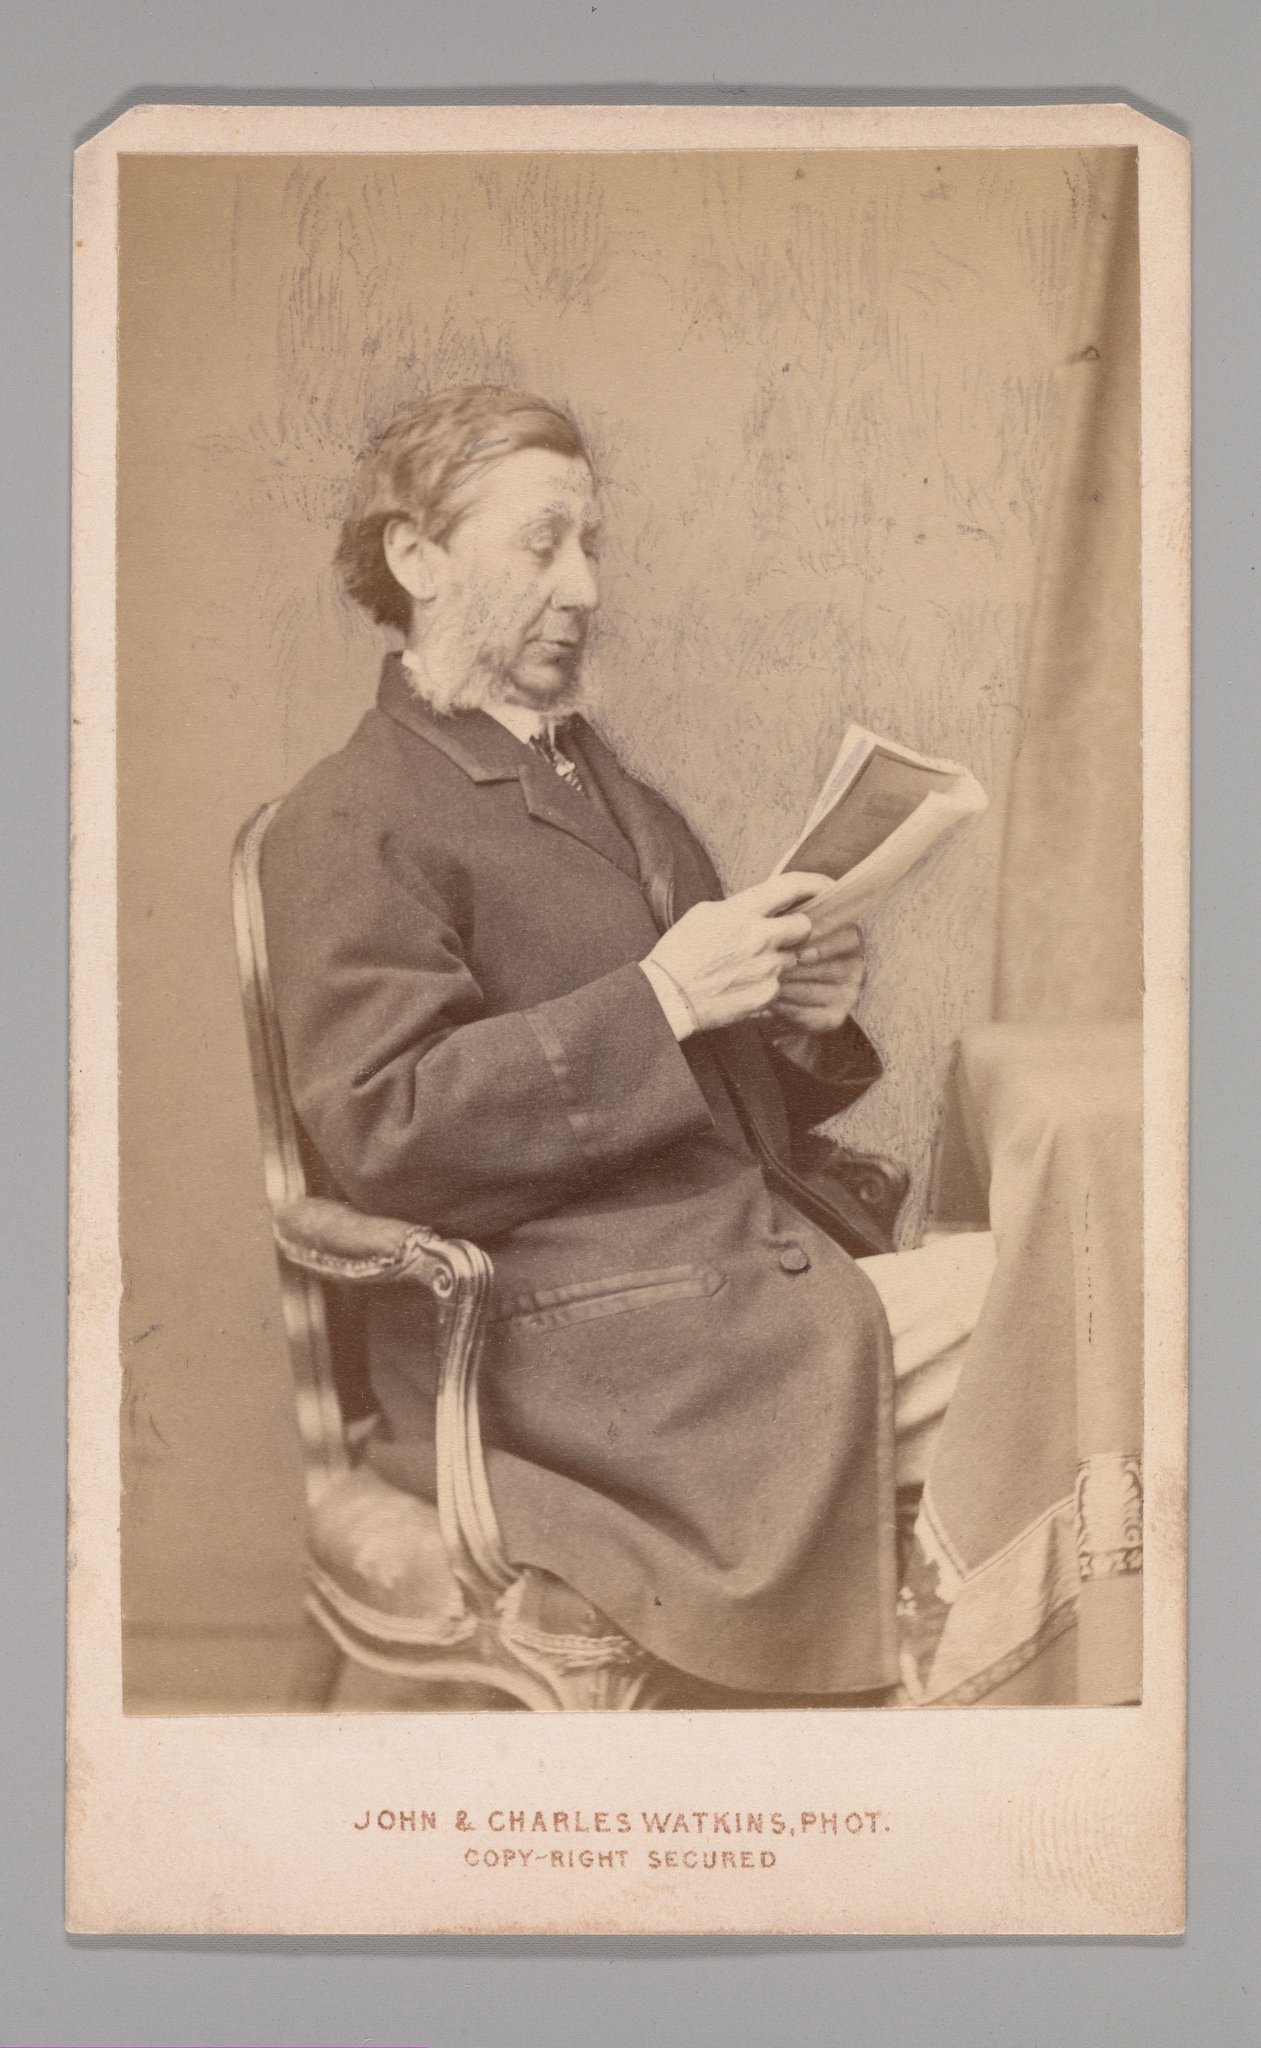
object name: carte de visite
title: [HenryJutsum]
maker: john and charles watkins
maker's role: photography studio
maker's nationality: british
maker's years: 1840-1875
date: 1860-1869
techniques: albumen silver print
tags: men,portraits,reading